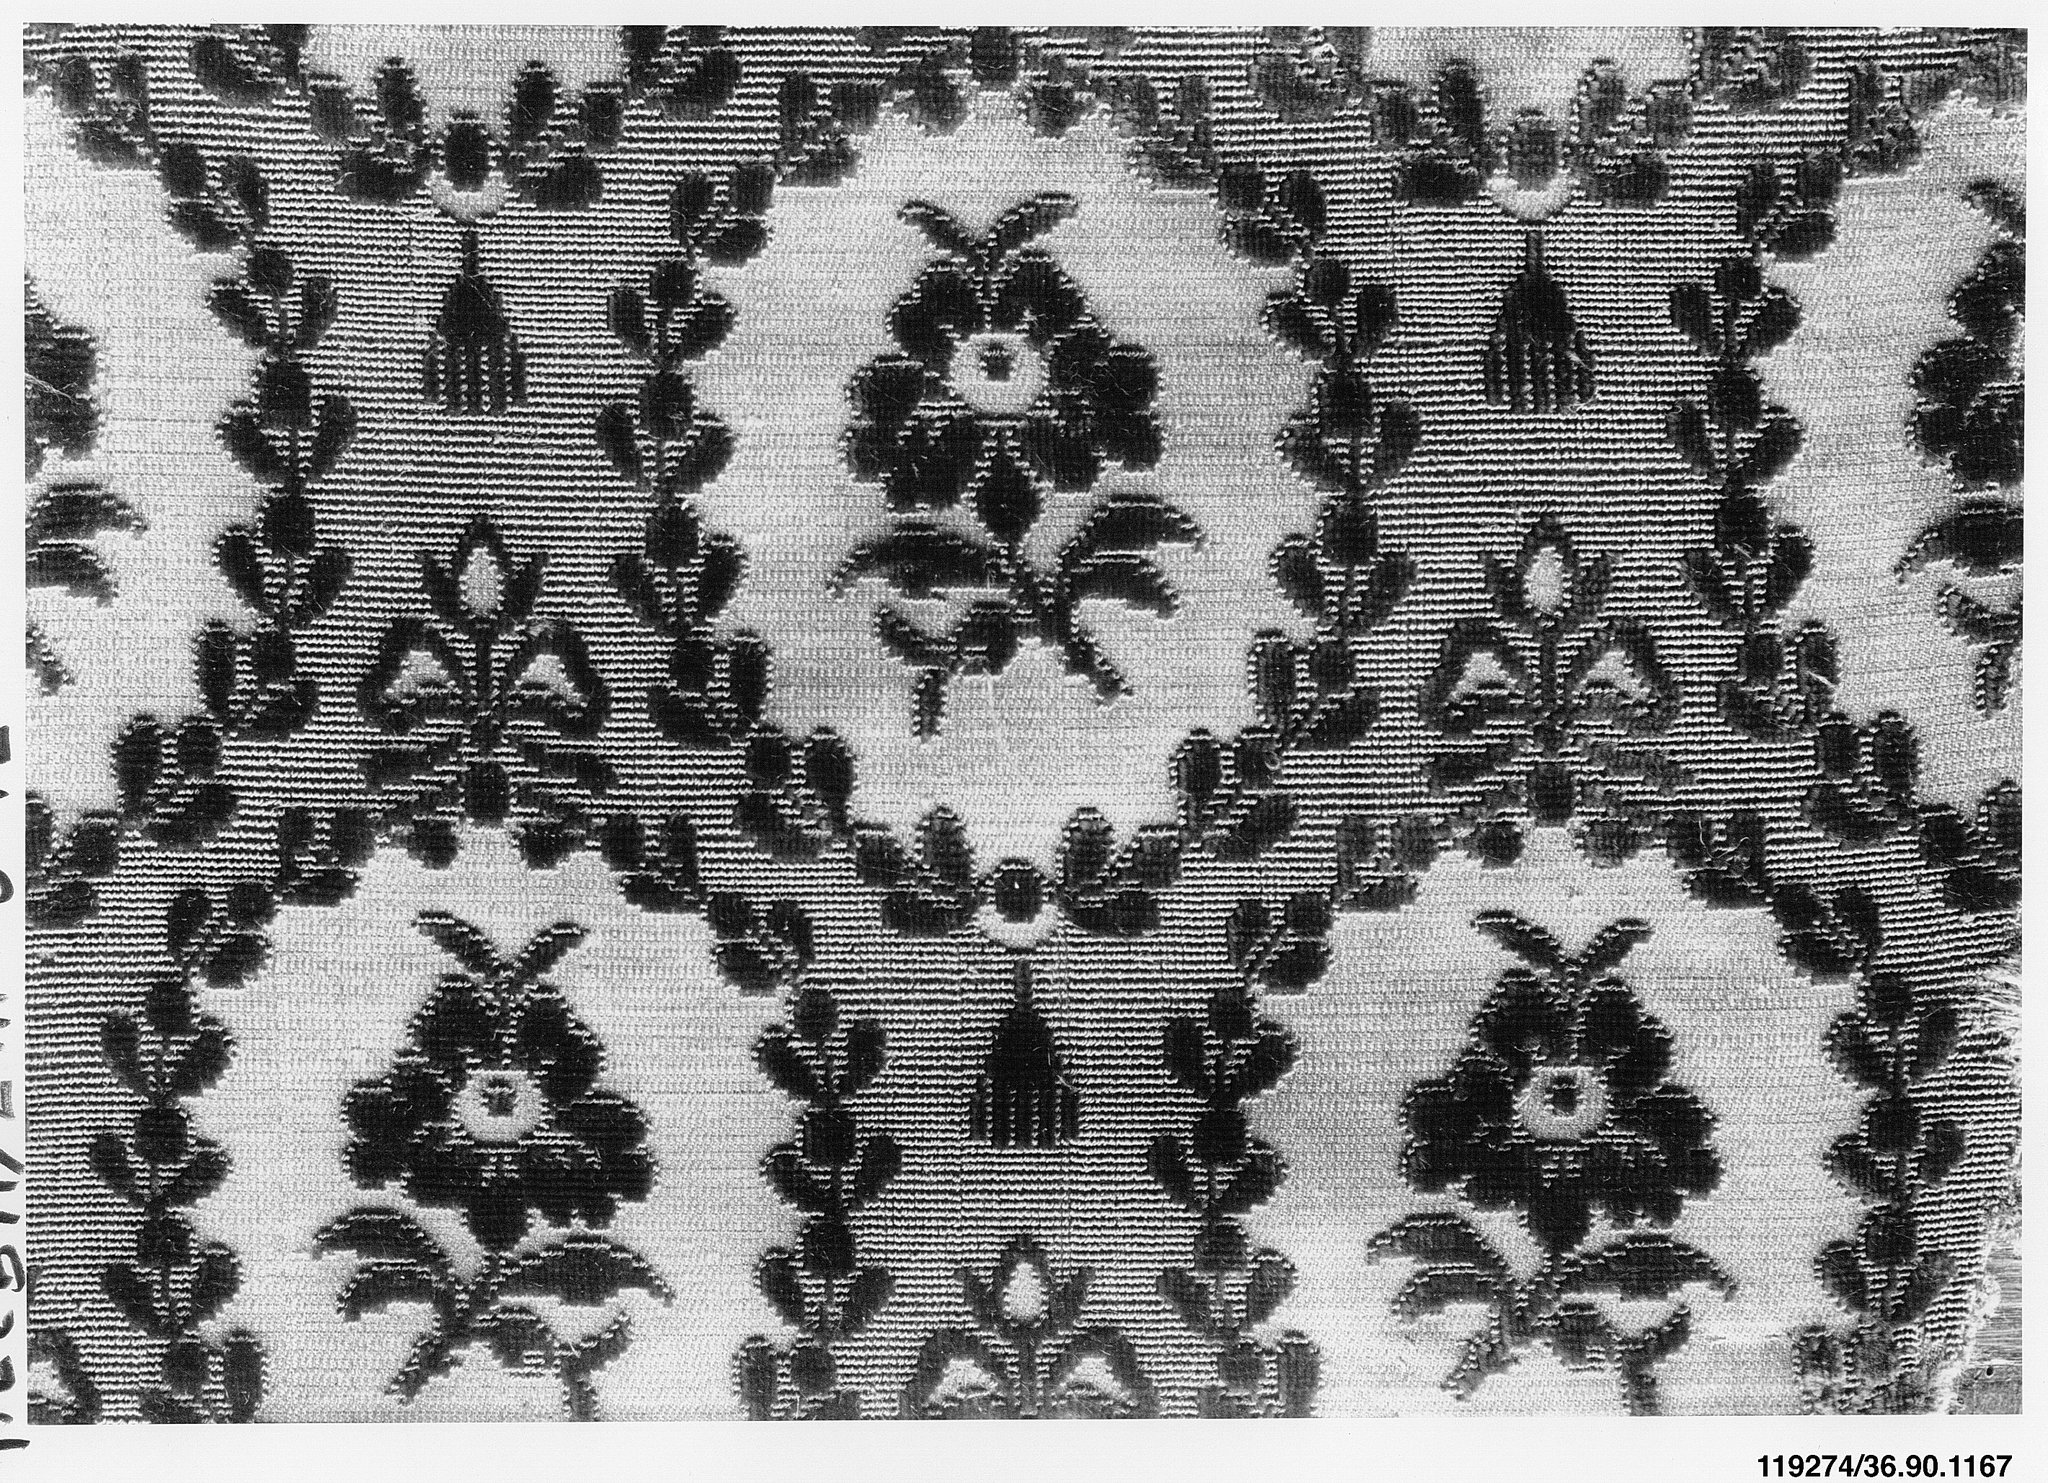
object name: piece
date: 1701-1800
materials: silk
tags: flowers,leaves